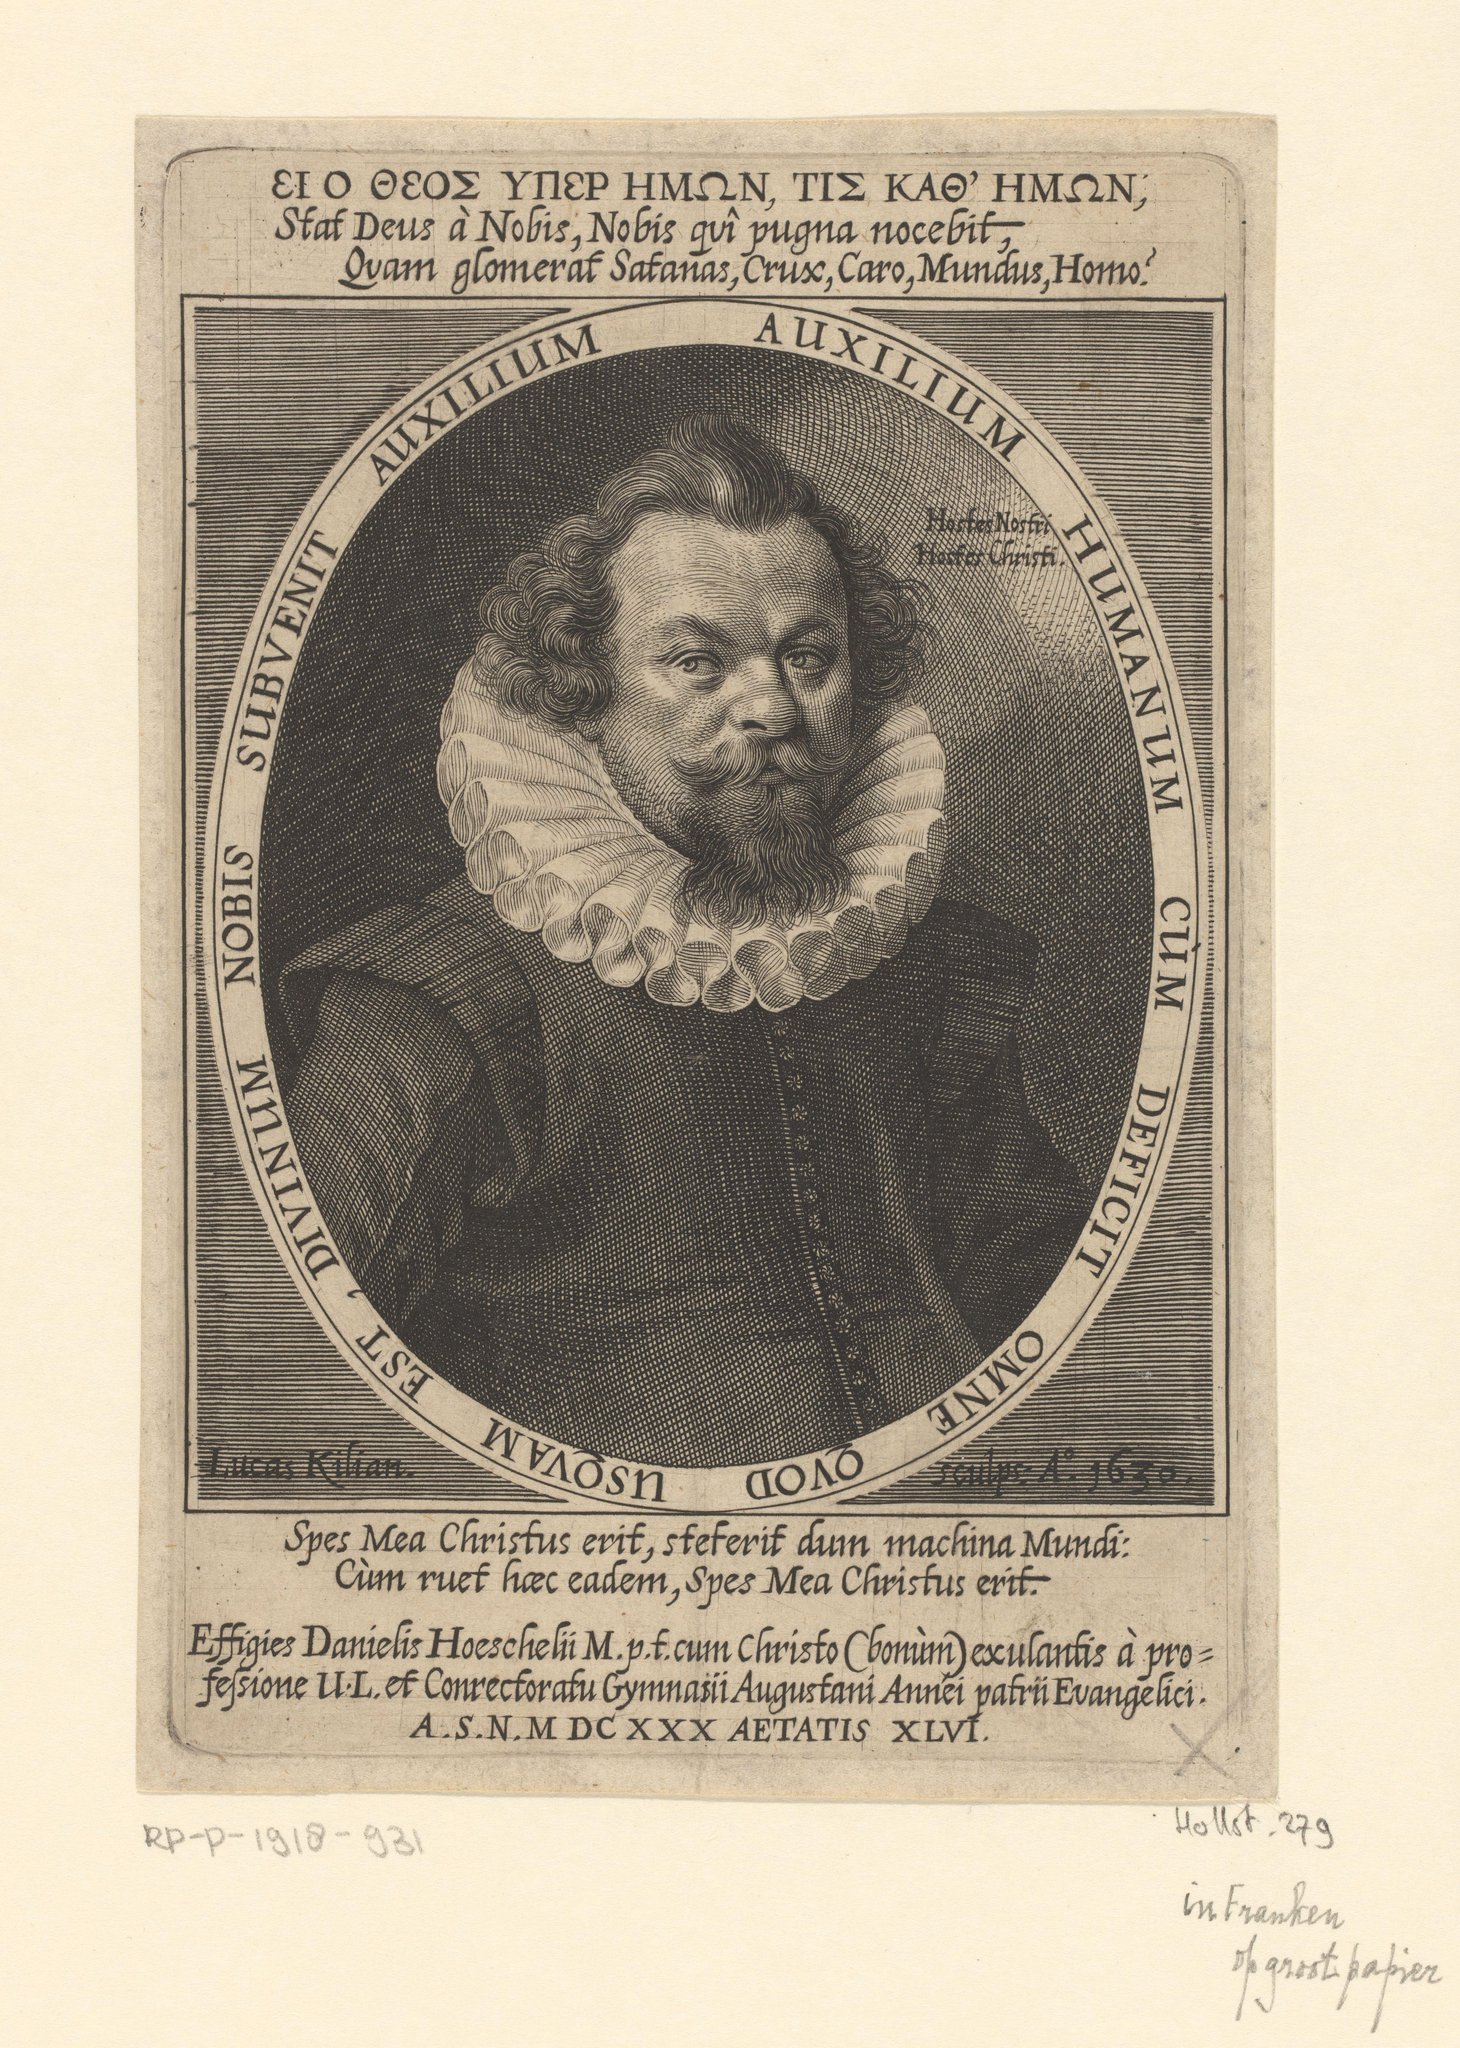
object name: print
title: Portret van Daniel Höschel op 46-jarige leeftijd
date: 1630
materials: paper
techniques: engraving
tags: augsburg, philology (+ portrait of scholar, scientist), historical persons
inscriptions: collector's mark: Lugt 2233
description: Tekst in het Latijn in de omlijsting, in de ondermarge en een regel in het Grieks in de bovenmarge.